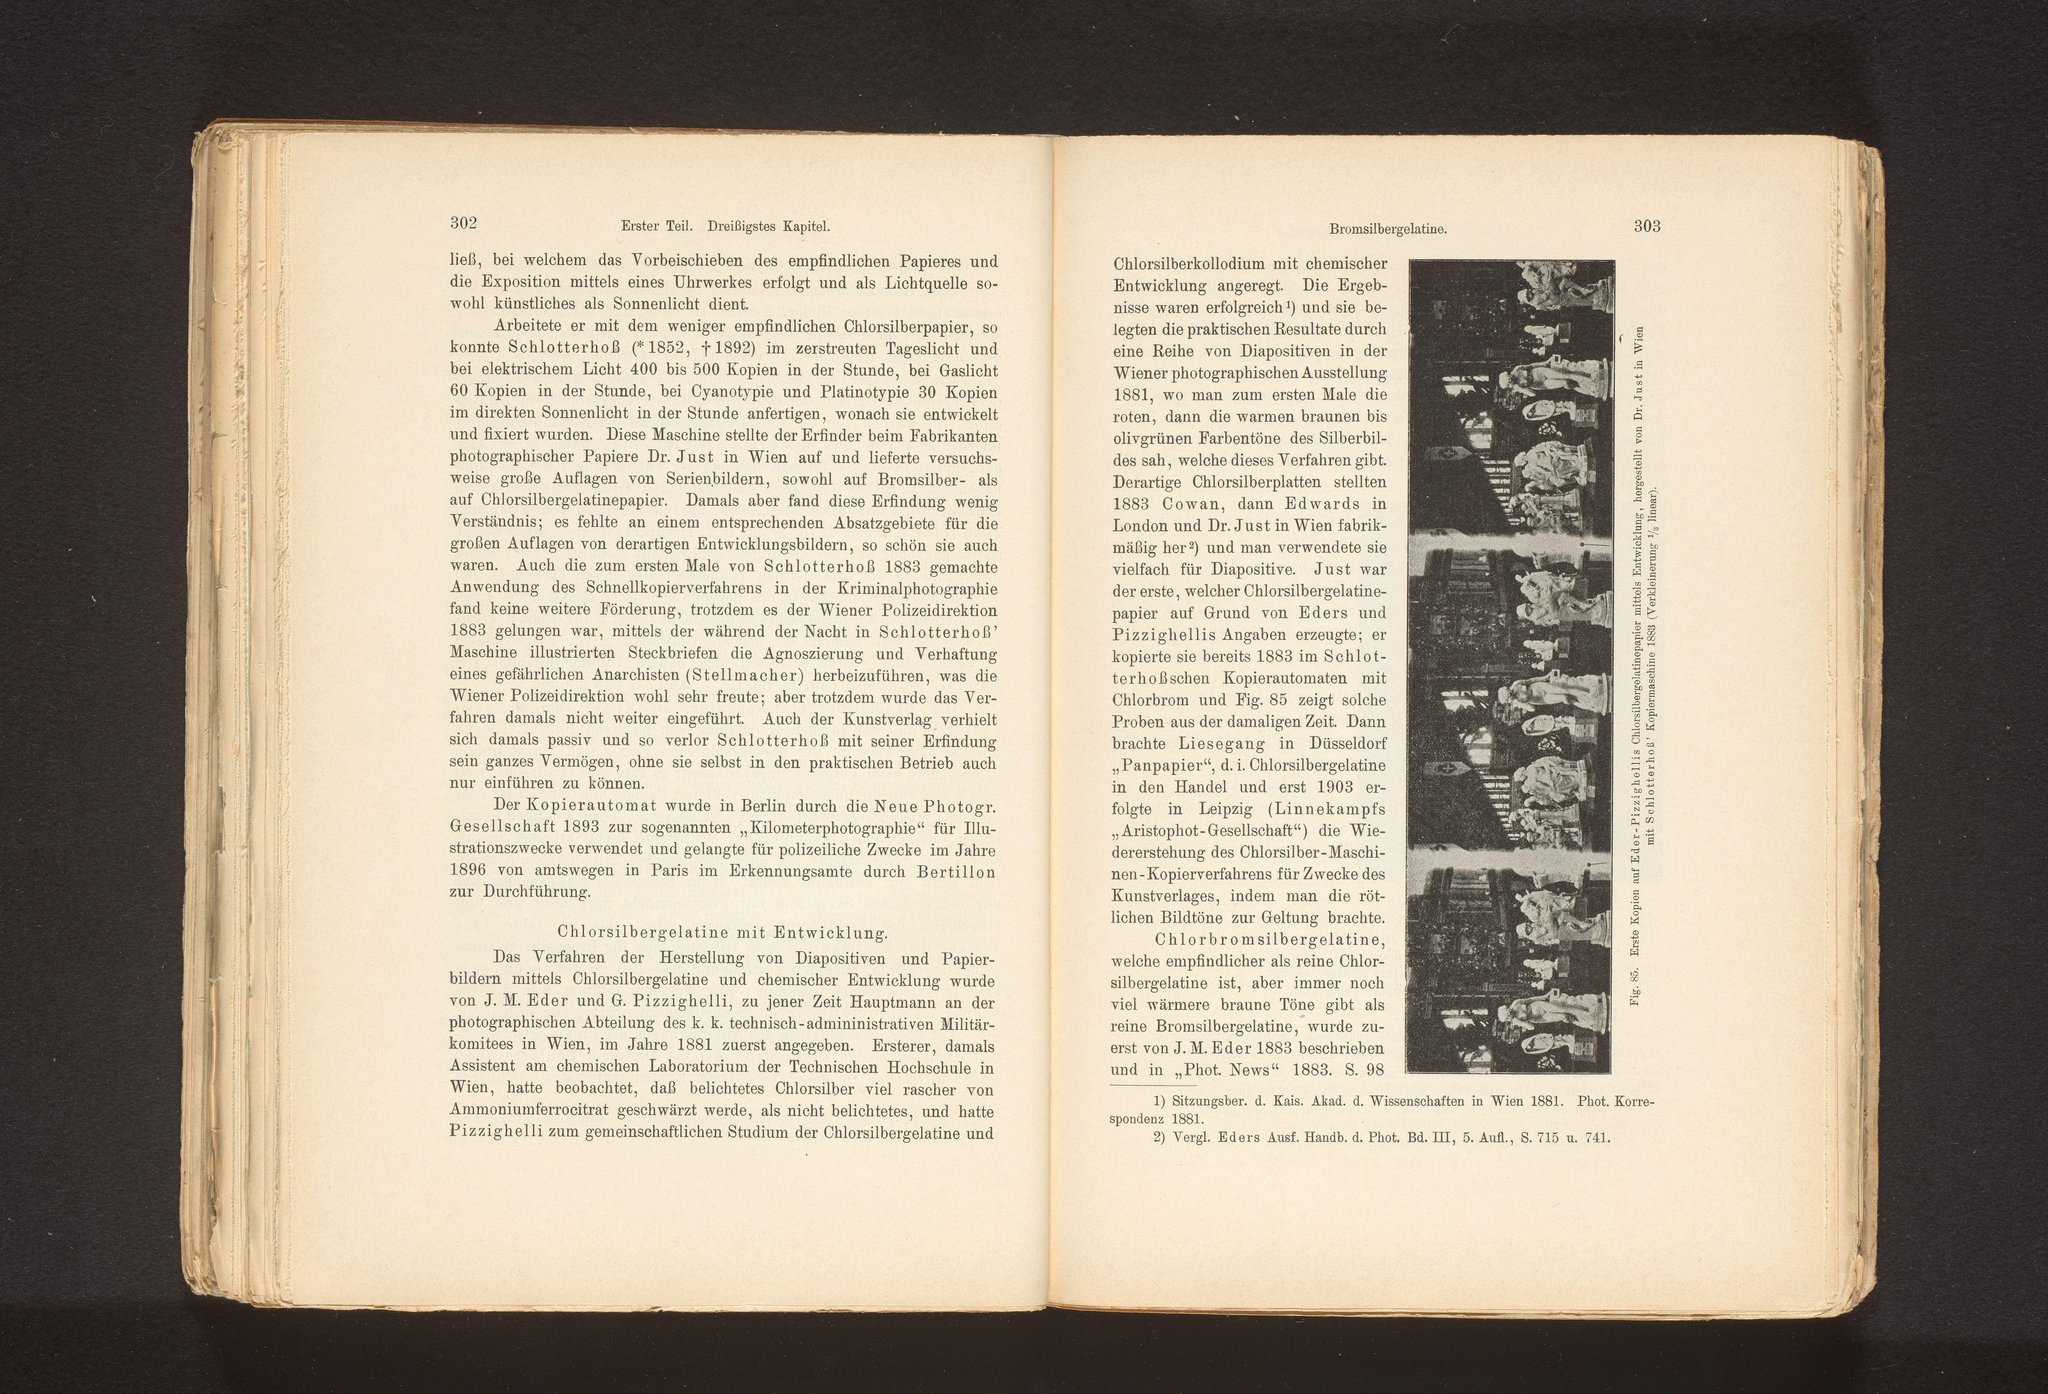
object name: photomechanical print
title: Drie interieurs van een beeldengalerij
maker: Anonymous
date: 1900-1905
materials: paper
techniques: autotype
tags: gallery of sculptures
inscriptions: number: ‘Fig. 85.’, inscription: ‘Erste Kopien (...) Kopiermaschine 1883 (Verkleinerung 1/3 linear)’